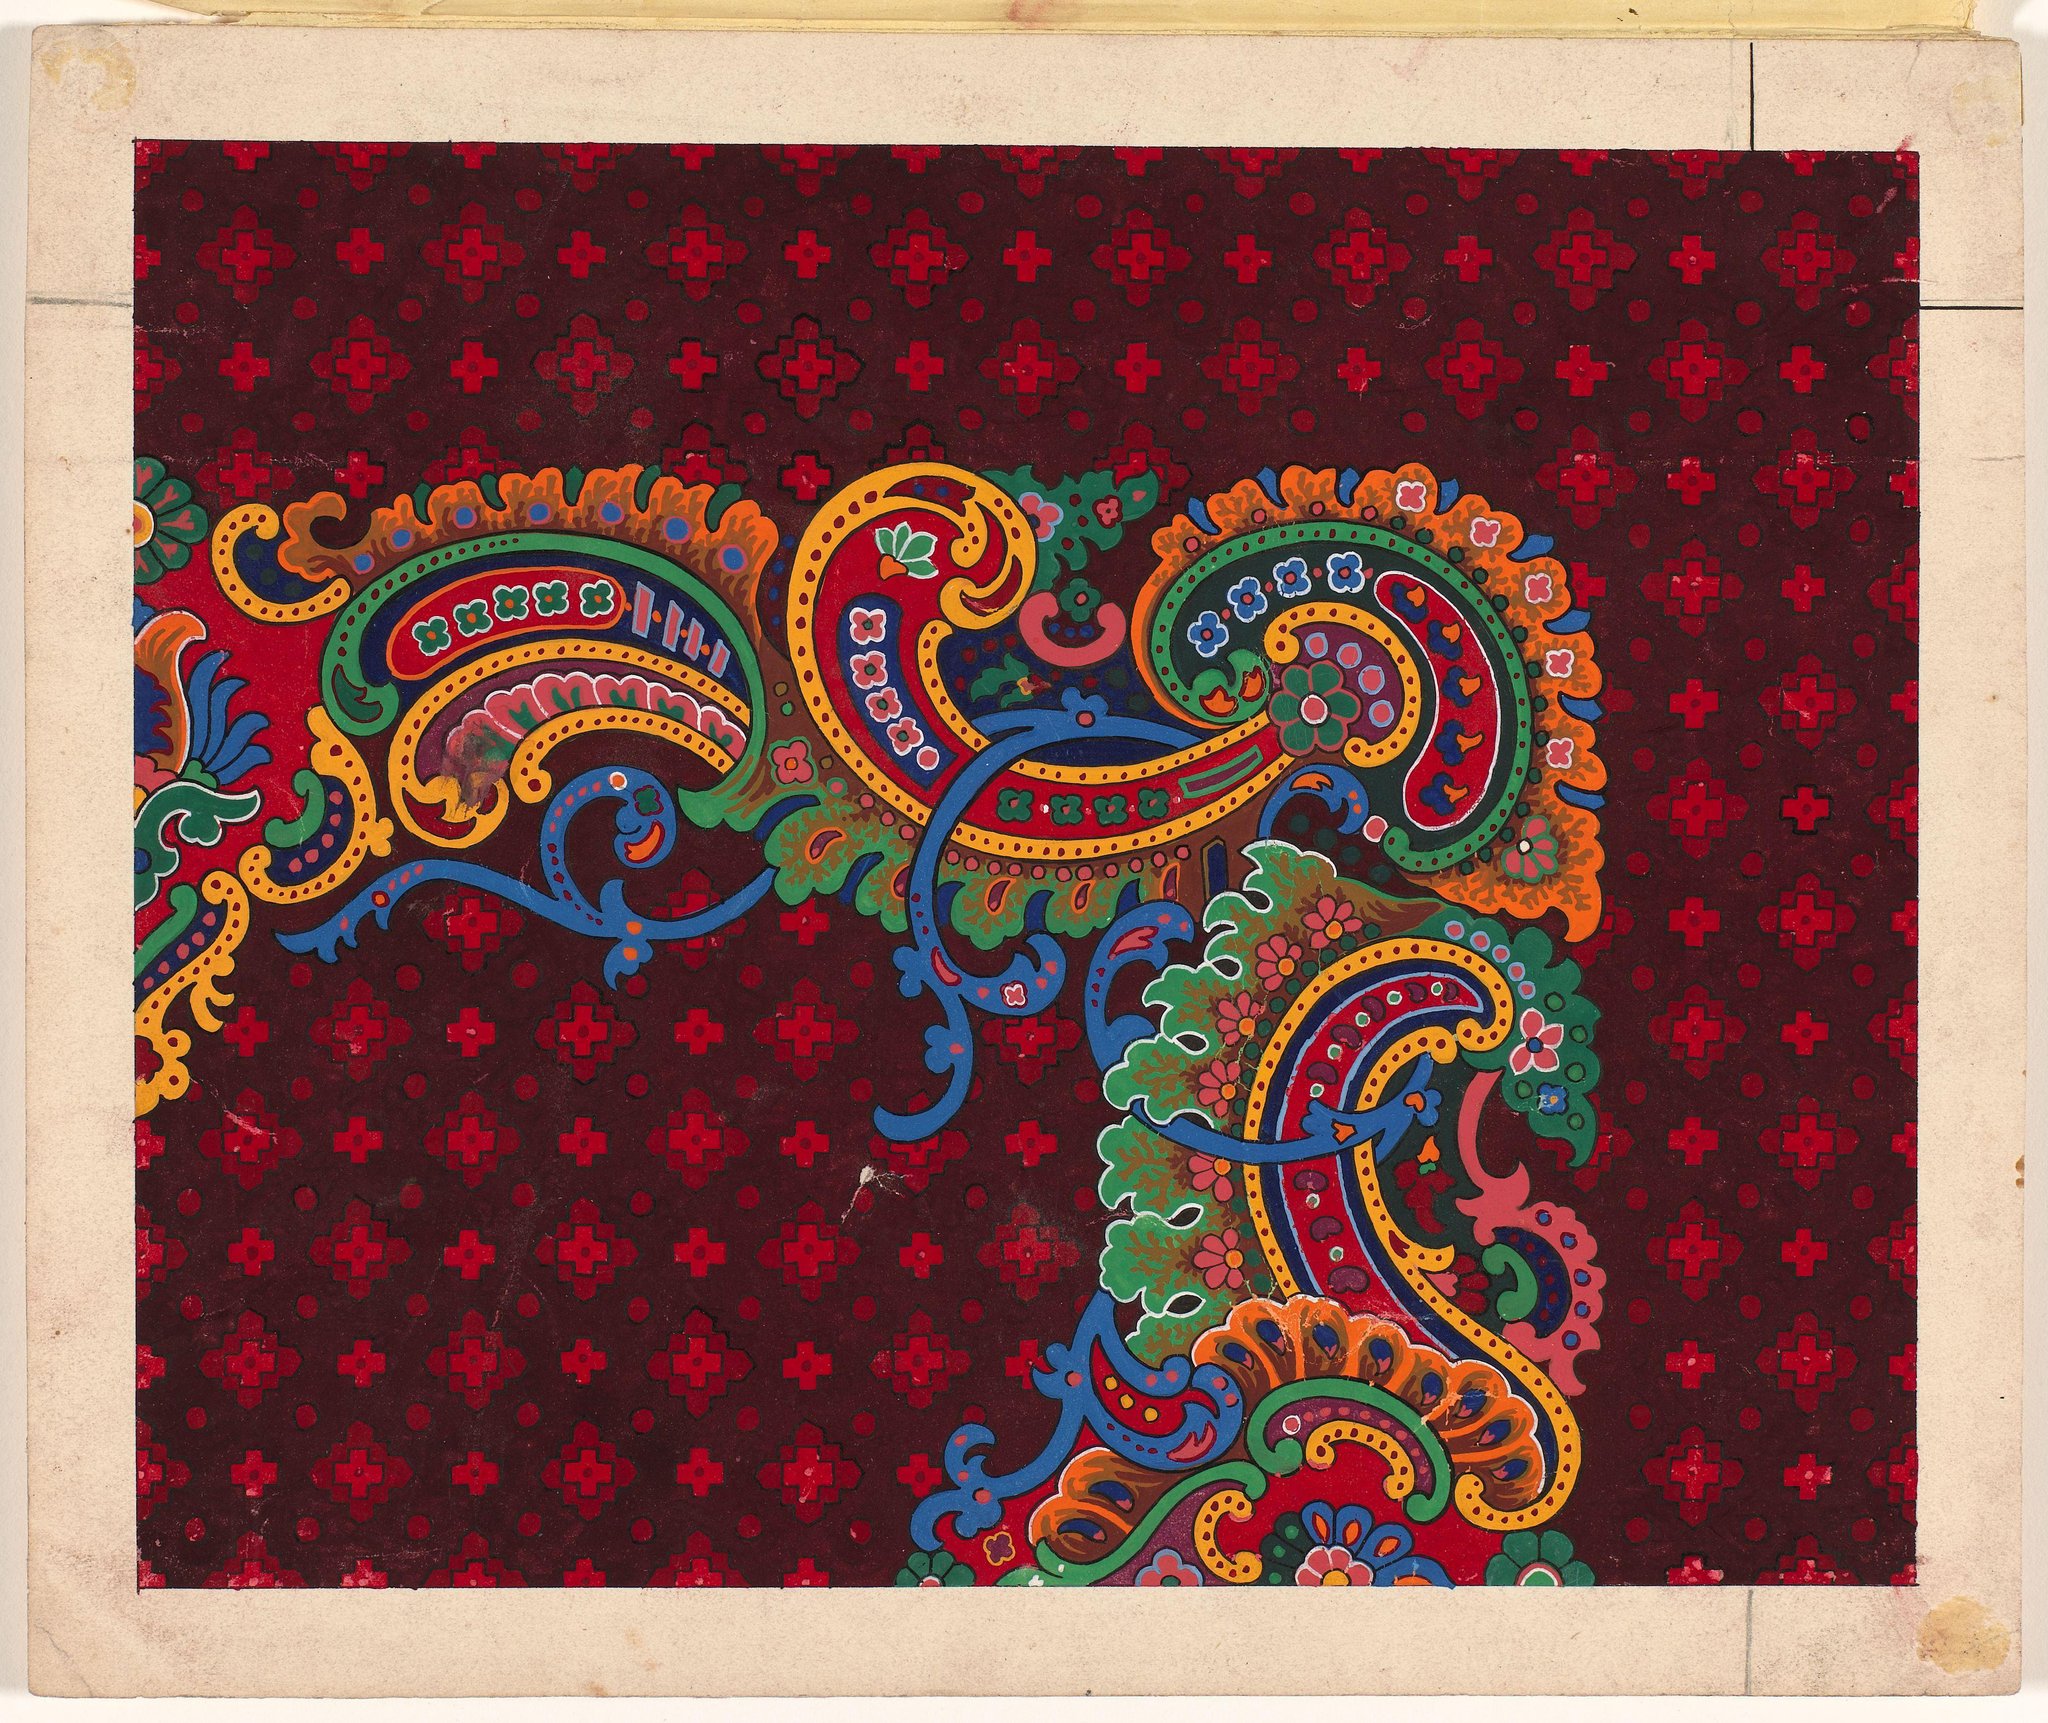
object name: drawing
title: Ontwerp voor een tapijt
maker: Anonymous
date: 1864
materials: gouache, paper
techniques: brush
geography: deventer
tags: ornaments ~ art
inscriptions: retailer's mark: ‘JHS.’, inscription: ‘Brief 20 Aug 1864.’, number: ‘No 50.II.’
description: De presentatietekeningen BK-1971-77-1 t/m 86 zijn kopieën van de originele ontwerptekeningen. Ze werden gemaakt voor vertegenwoordigers van bijvoorbeeld magazijnen, die ze aan hun klanten konden tonen. De meeste tekeningen tonen een kwart van het dessin inclusief rand, middenpartij (de zogenaamde grond of fond) en centraal medaillon. Door het gebruik van spiegels kan de illusie van het gehele tapijt worden opgeroepen. Een deel van de tekeningen heeft een alfabetische opeenvolgende letter als kenmerk, de andere groep een cijfer.Waarschijnlijk is de reeks dessins met een letter eerder samengesteld dan de genummerde tekeningen.